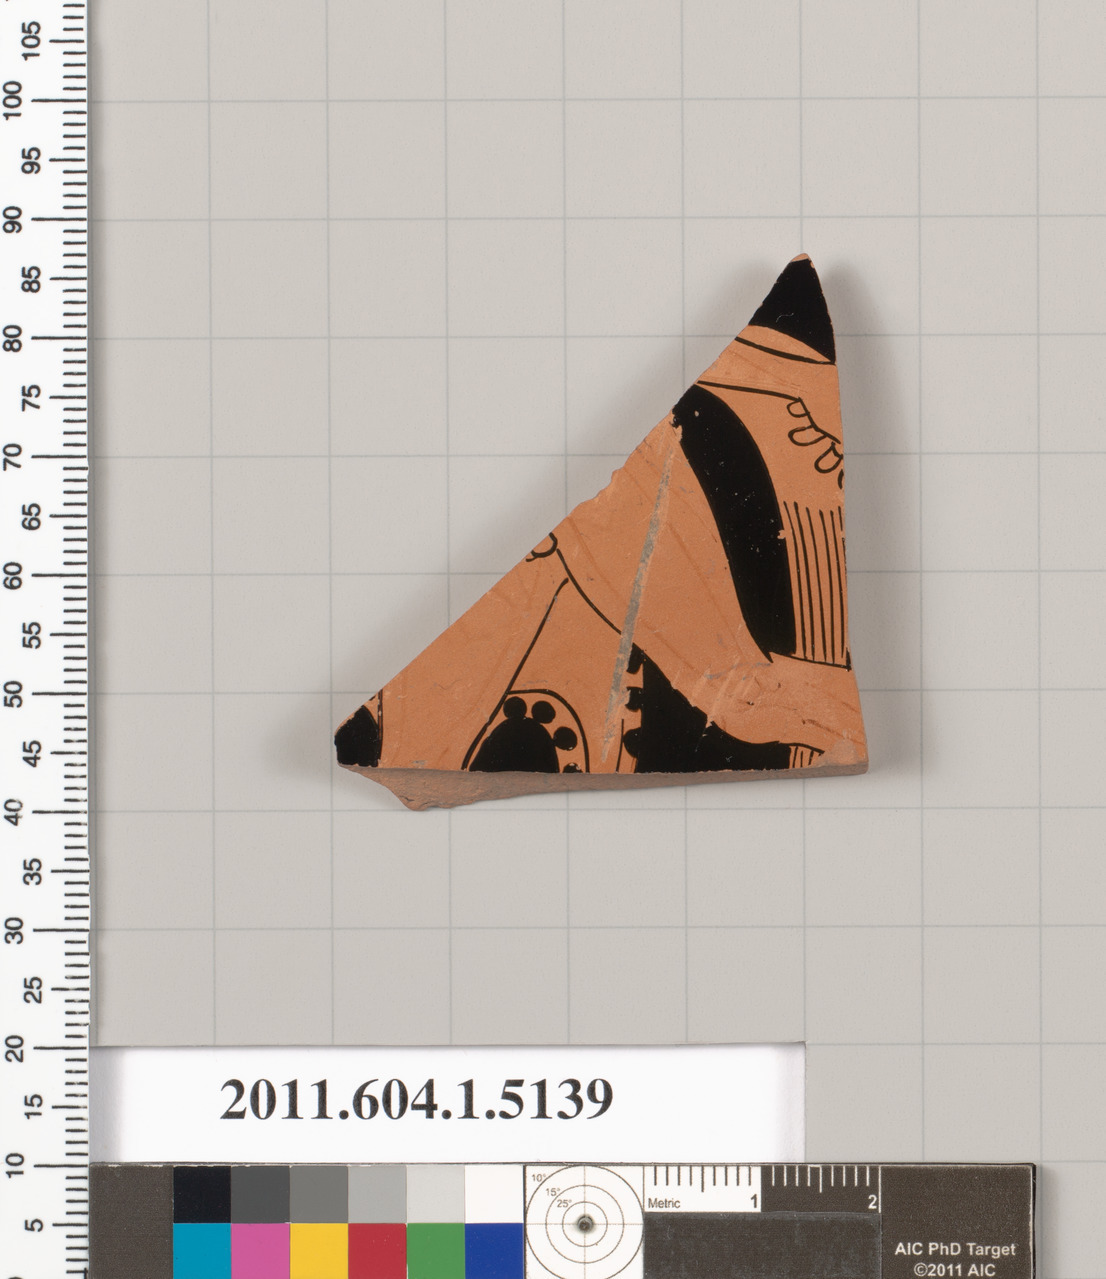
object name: kylix fragment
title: Terracotta fragment of a kylix (drinking cup)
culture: greek, attic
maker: onesimos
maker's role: artist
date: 490-480 BCE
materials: terracotta